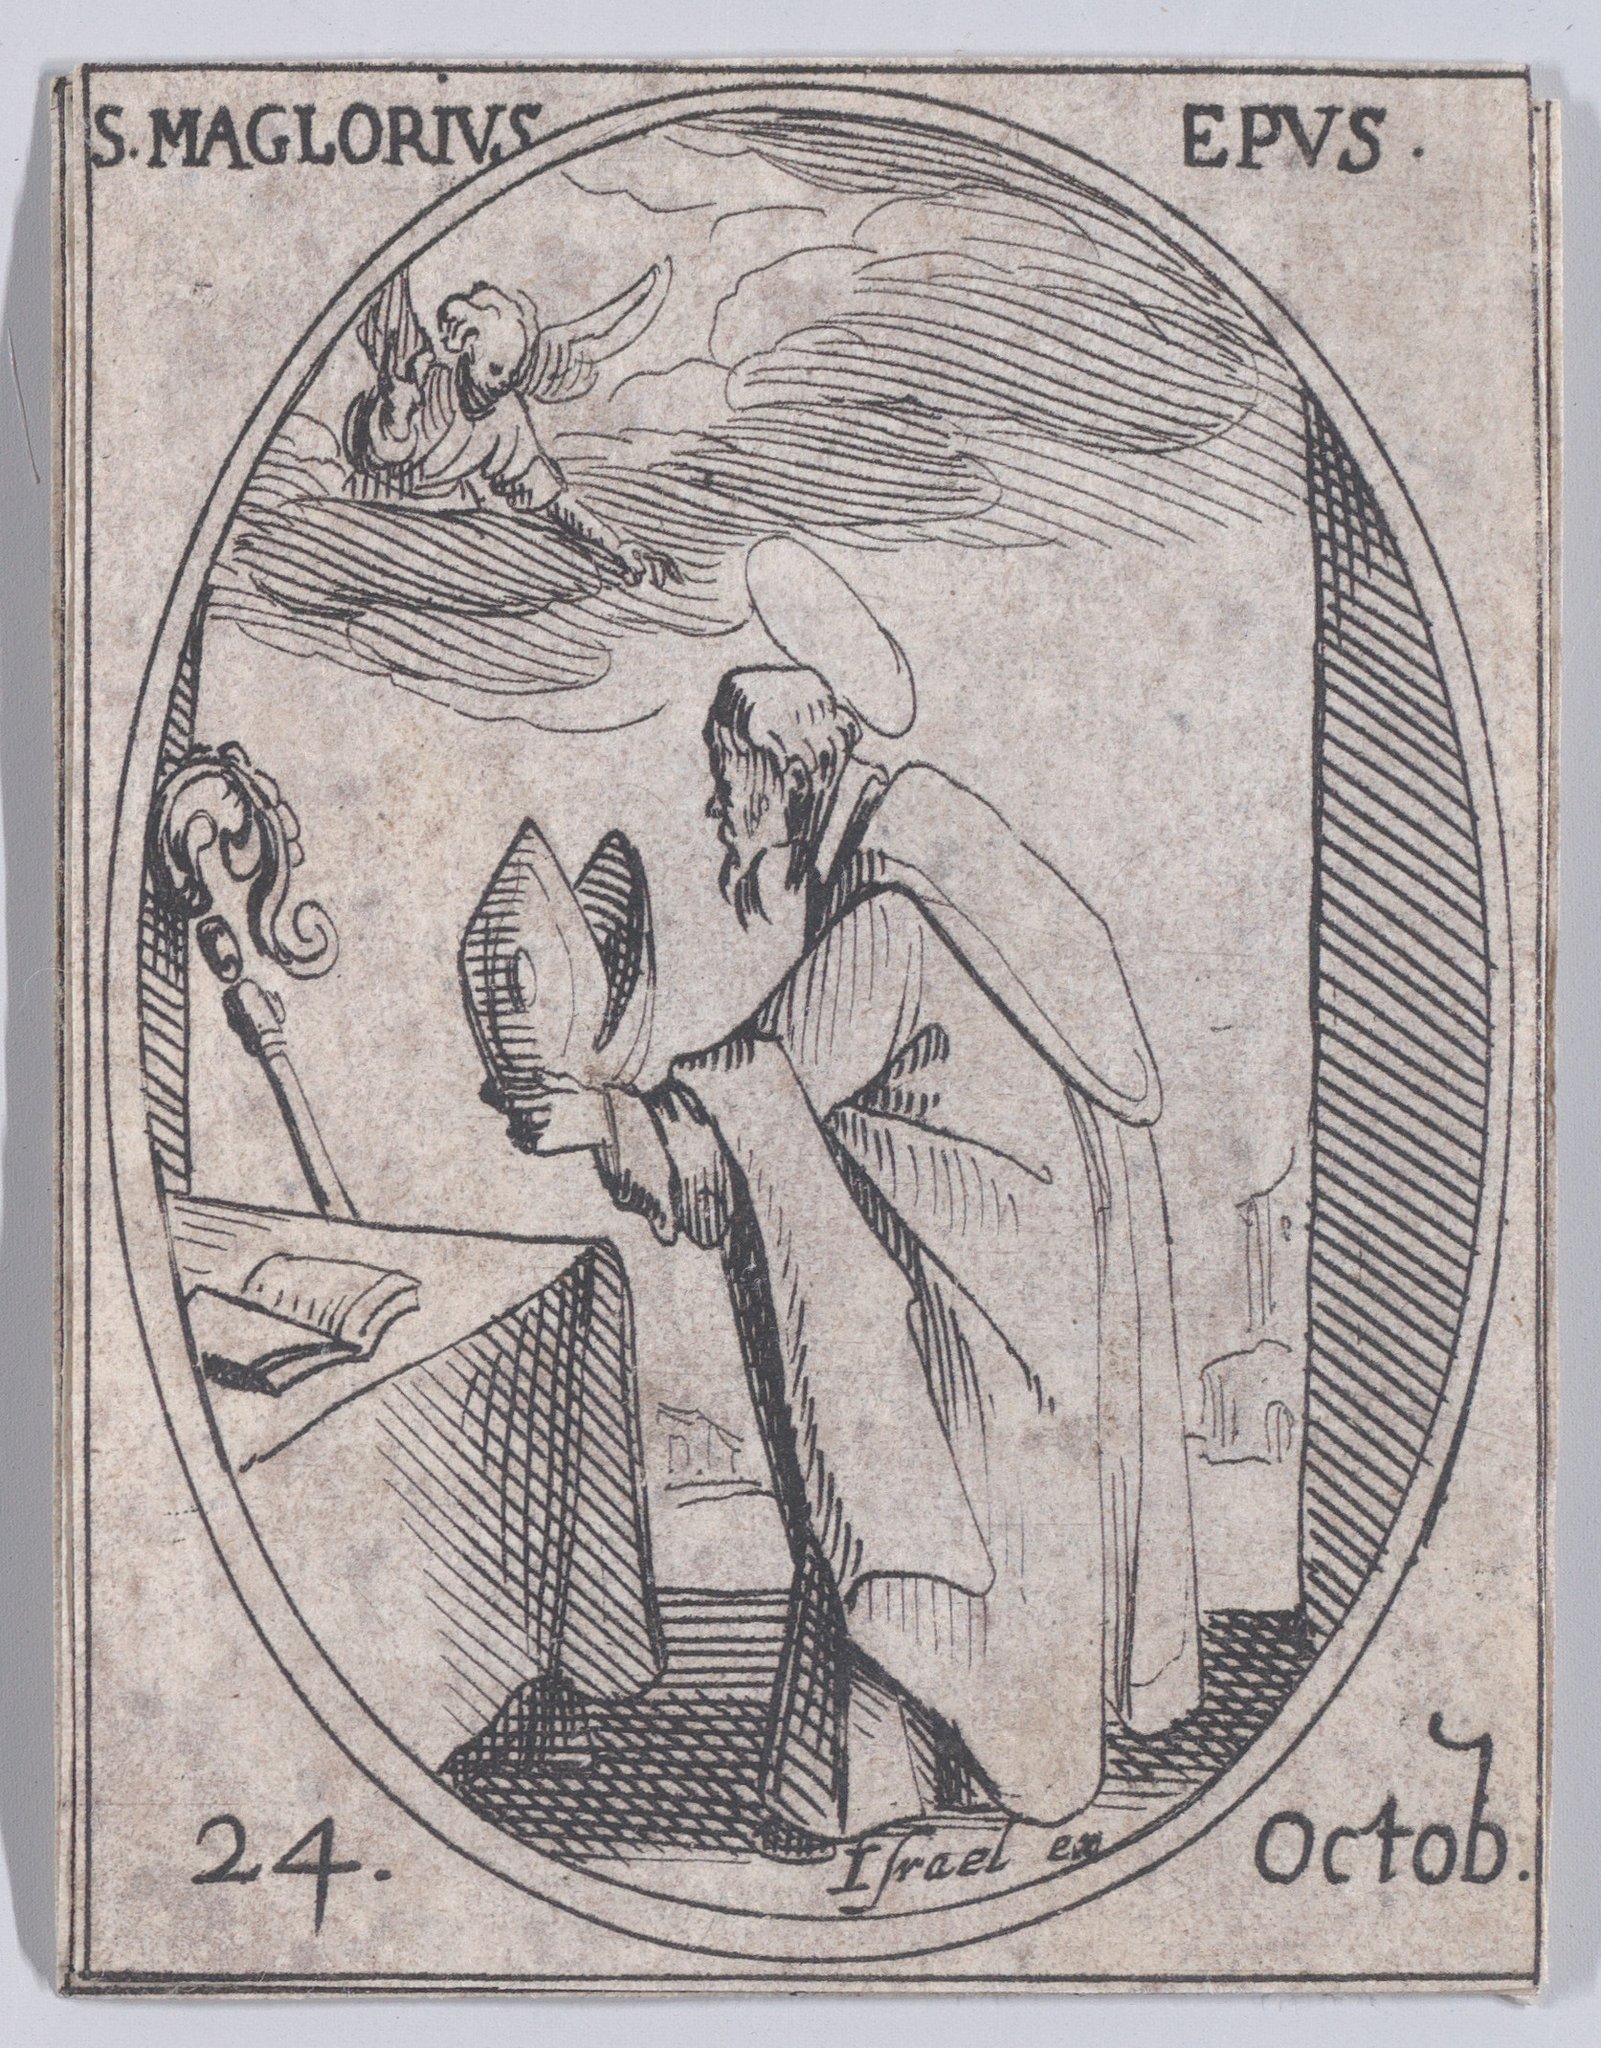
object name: print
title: S. Magloire, évêque (St. Maglorius, Bishop), October 24th, from "Les Images De Tous Les Saincts et Saintes de L'Année" (Images of All of the Saints and Religious Events of the Year)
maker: jacques callot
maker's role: artist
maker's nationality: french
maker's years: 1592-1635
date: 1636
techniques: etching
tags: men,bishops,saints